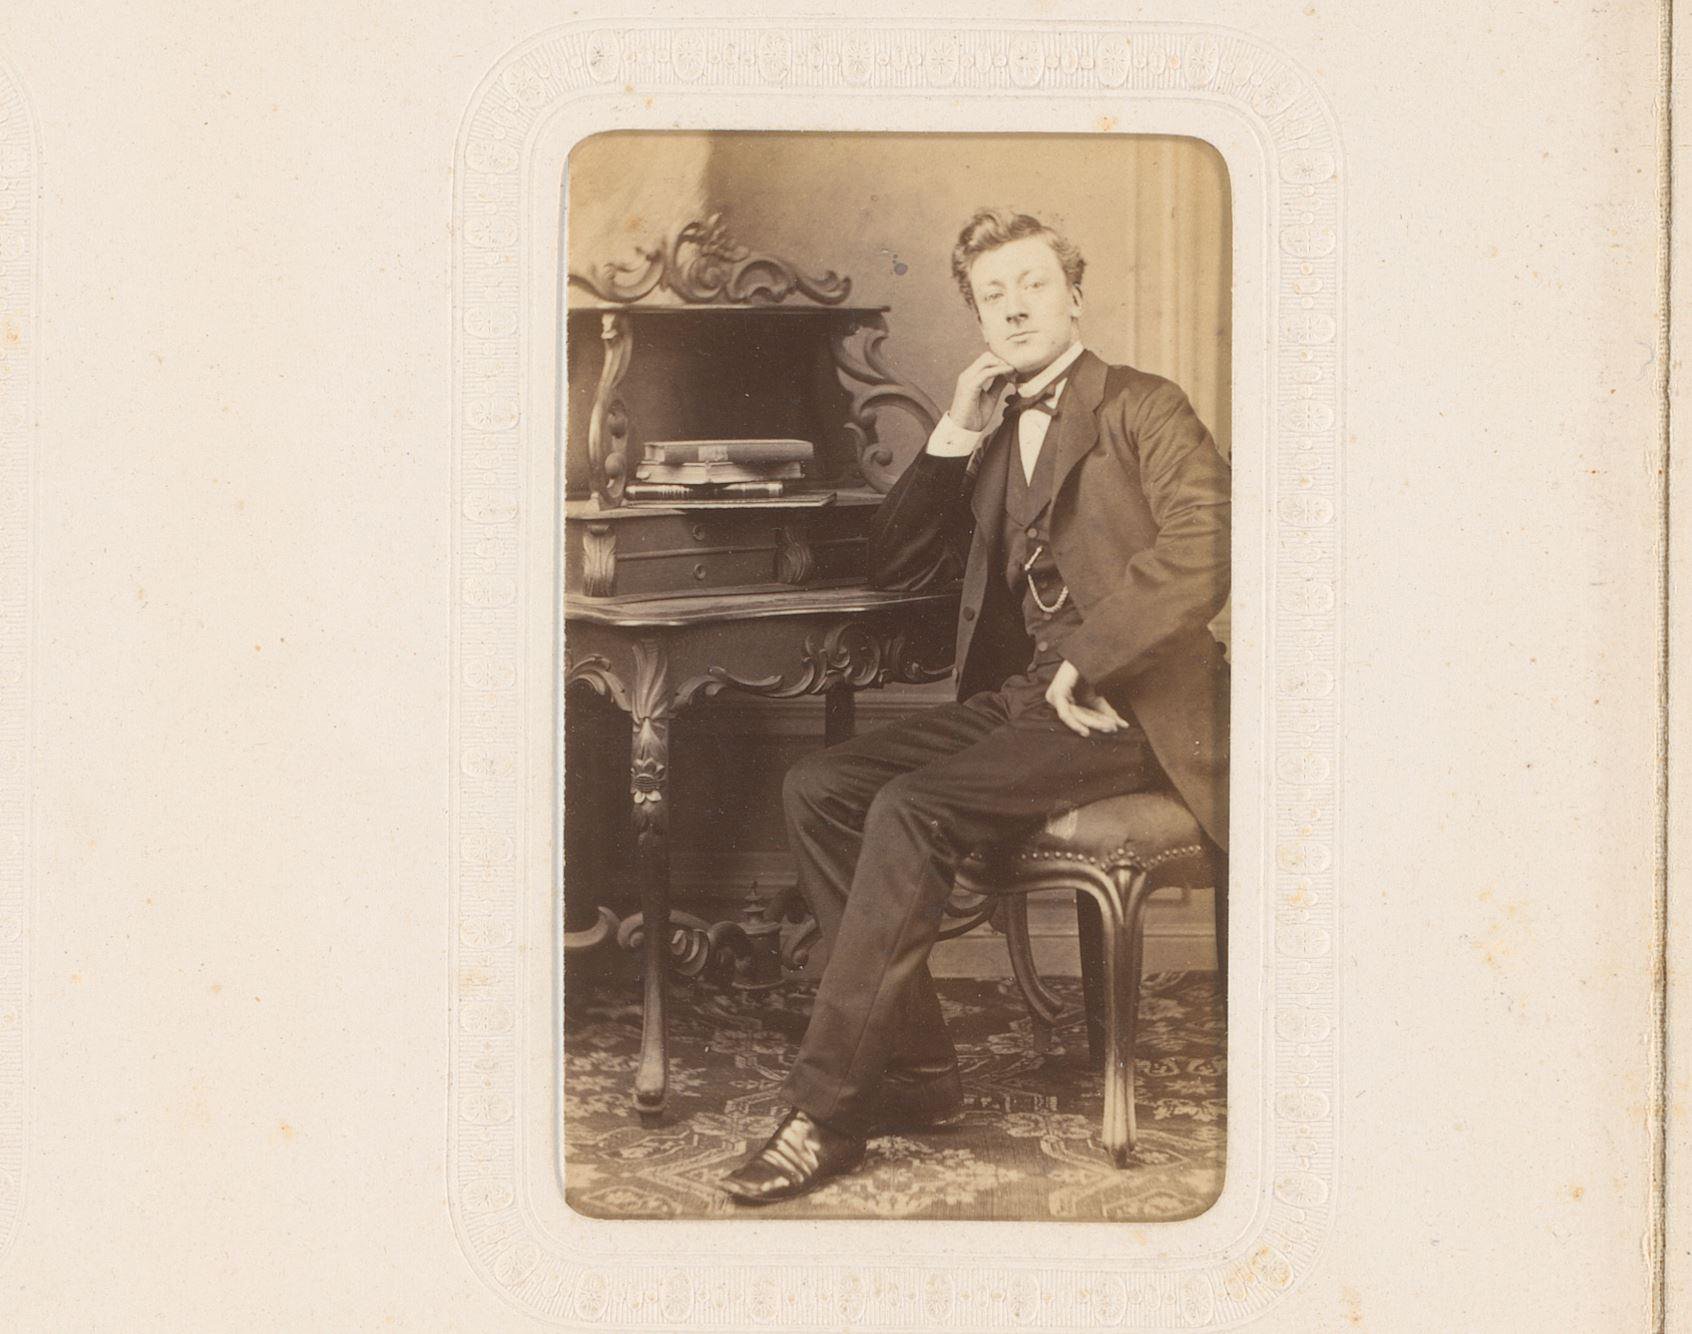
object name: carte de visite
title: Portret van een zittende jonge man aan een schrijftafel, aangeduid als Jo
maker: Anonymous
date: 1860-1900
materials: cardboard, photographic support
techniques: albumen print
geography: netherlands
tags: writing-table, writing-desk, sitting figure, historical persons, youth, adolescent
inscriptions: annotation: ‘O[..]n Jo.’